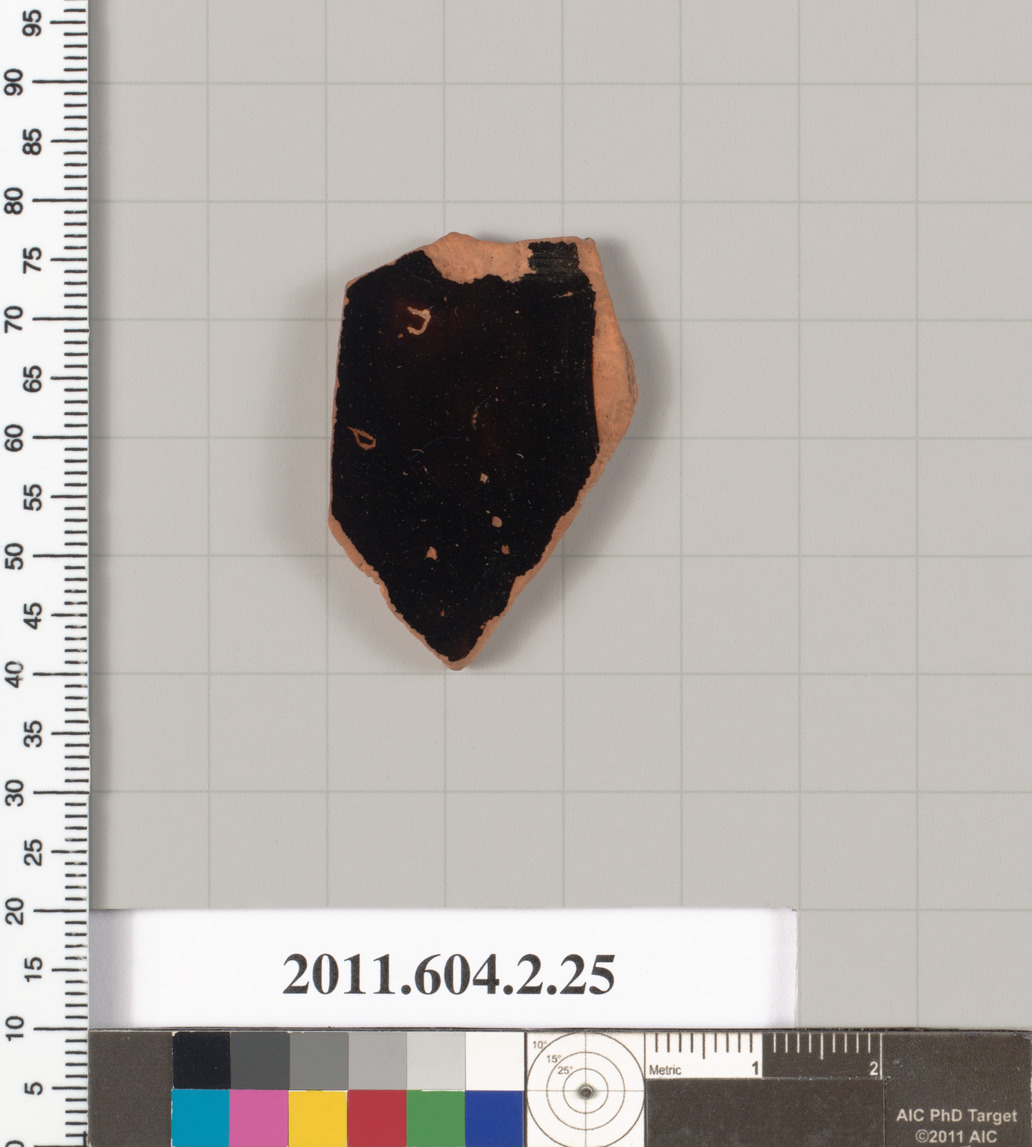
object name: psykter fragment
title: Terracotta fragment of a psykter (vase for cooling wine)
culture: greek, attic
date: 520-500 BCE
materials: terracotta